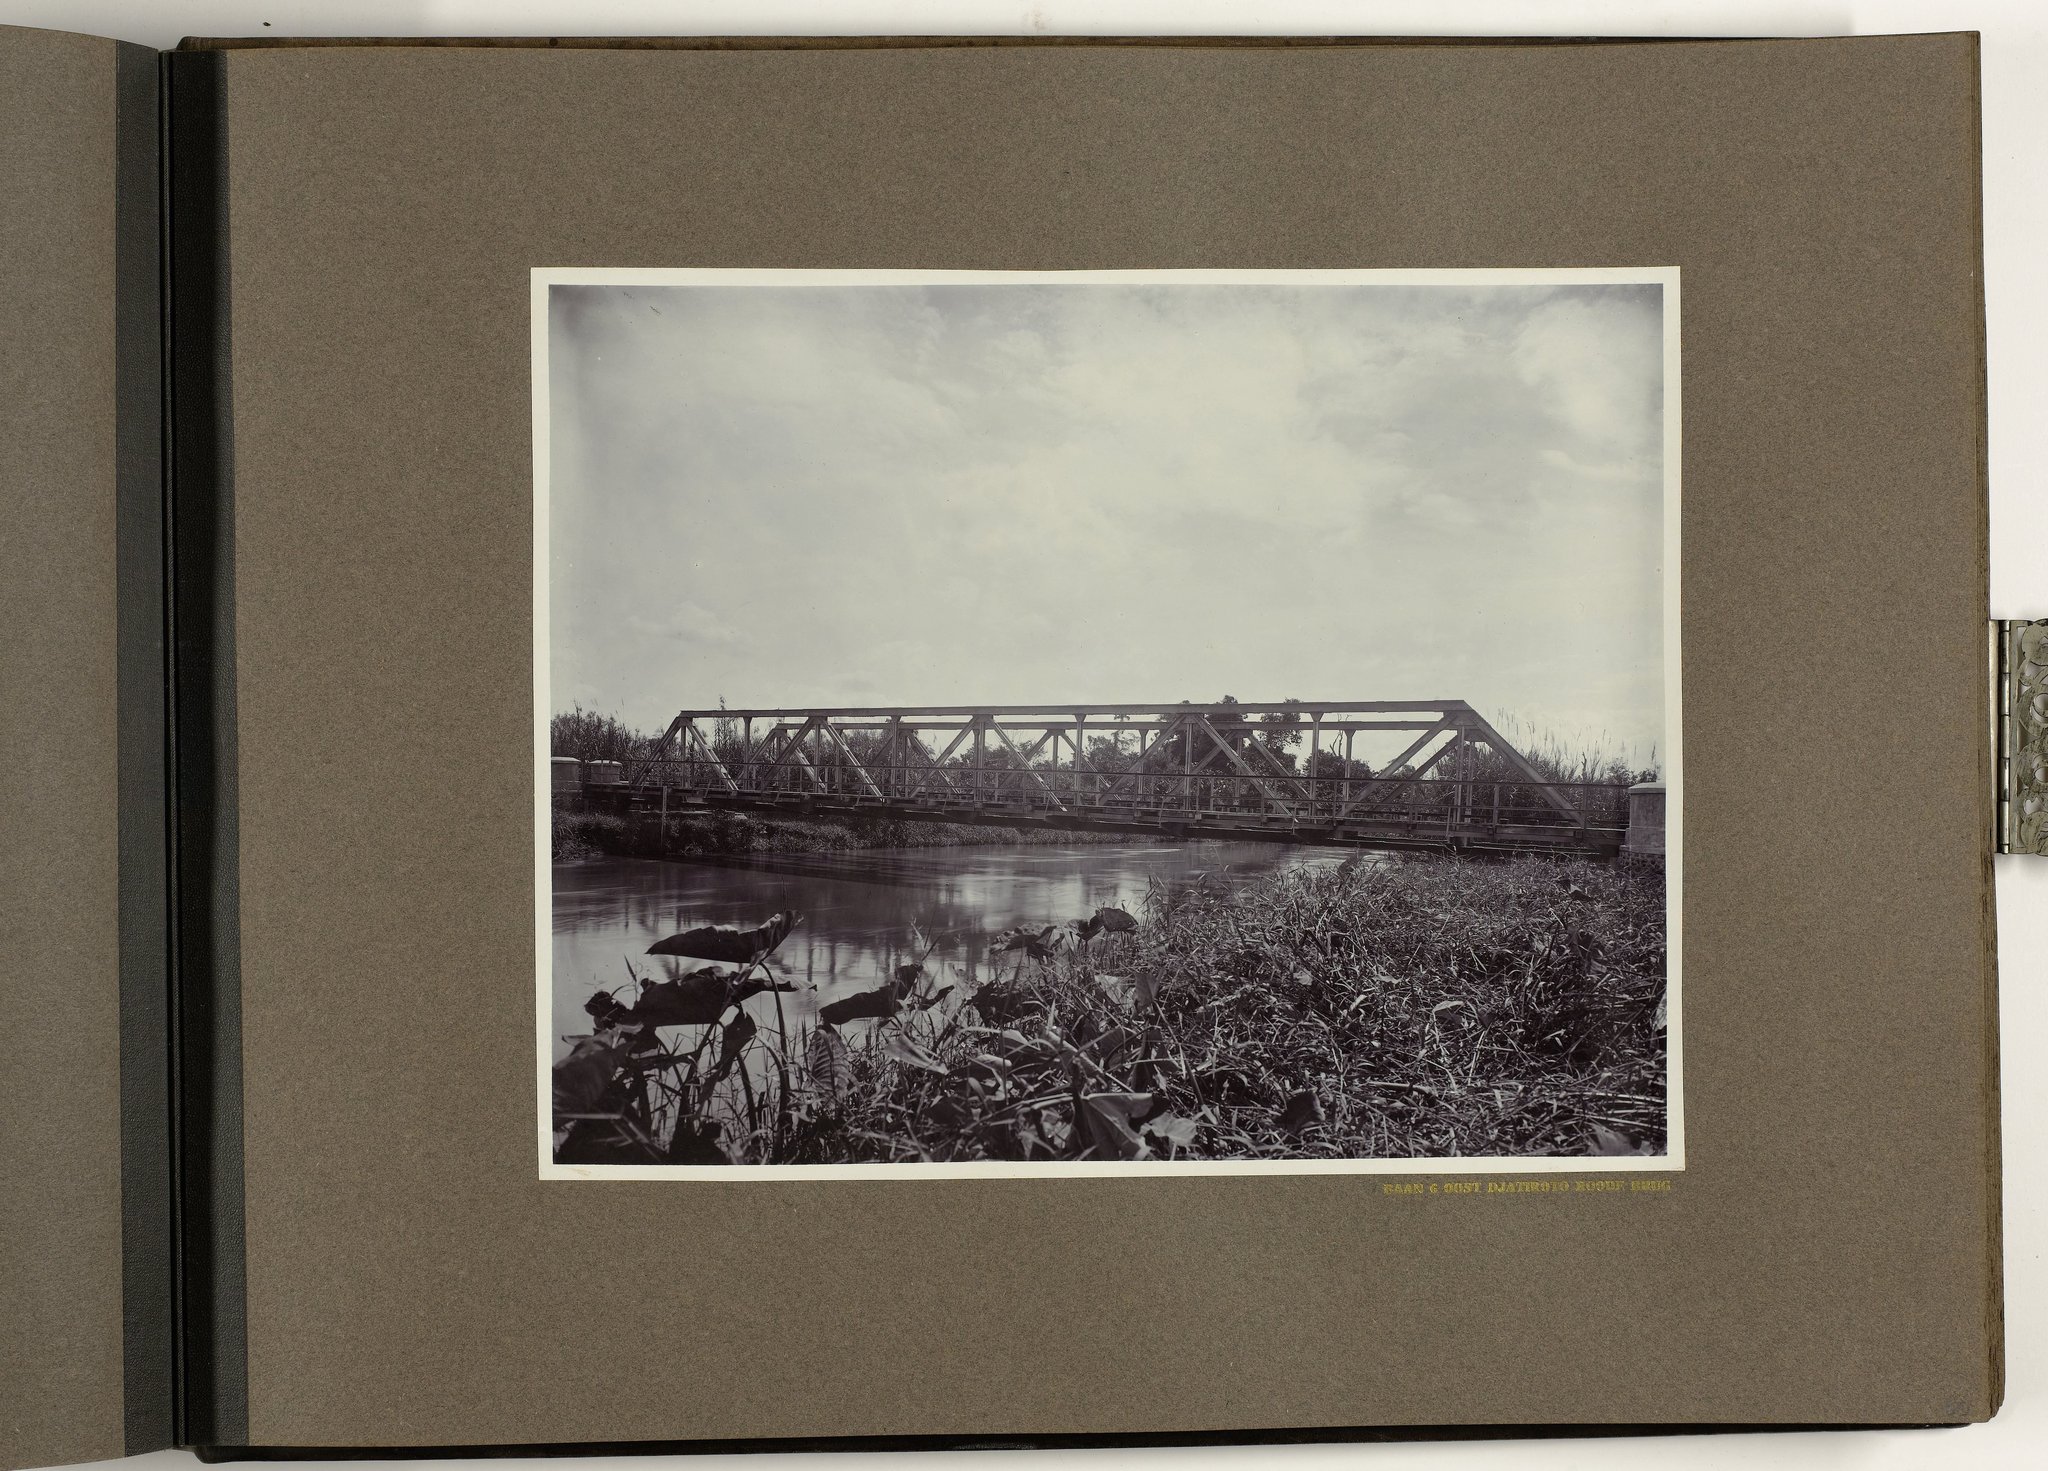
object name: photograph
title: Baan 6 Oost Djatiroto Roode brug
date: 1917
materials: photographic support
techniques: gelatin silver print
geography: jatiroto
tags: colonial system, (non-fruit) products of plants or trees: sugarcane, bridge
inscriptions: inscription: ‘BAAN 6 OOST DJATIROTO ROODE BRUG’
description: Metalen spoorbrug over een rivier op het terrein van de suikerfabriek. Onderdeel van het fotoalbum aangeboden aan F.J. Wirix door het personeel van de Suikeronderneming Djatiroto in 1917.